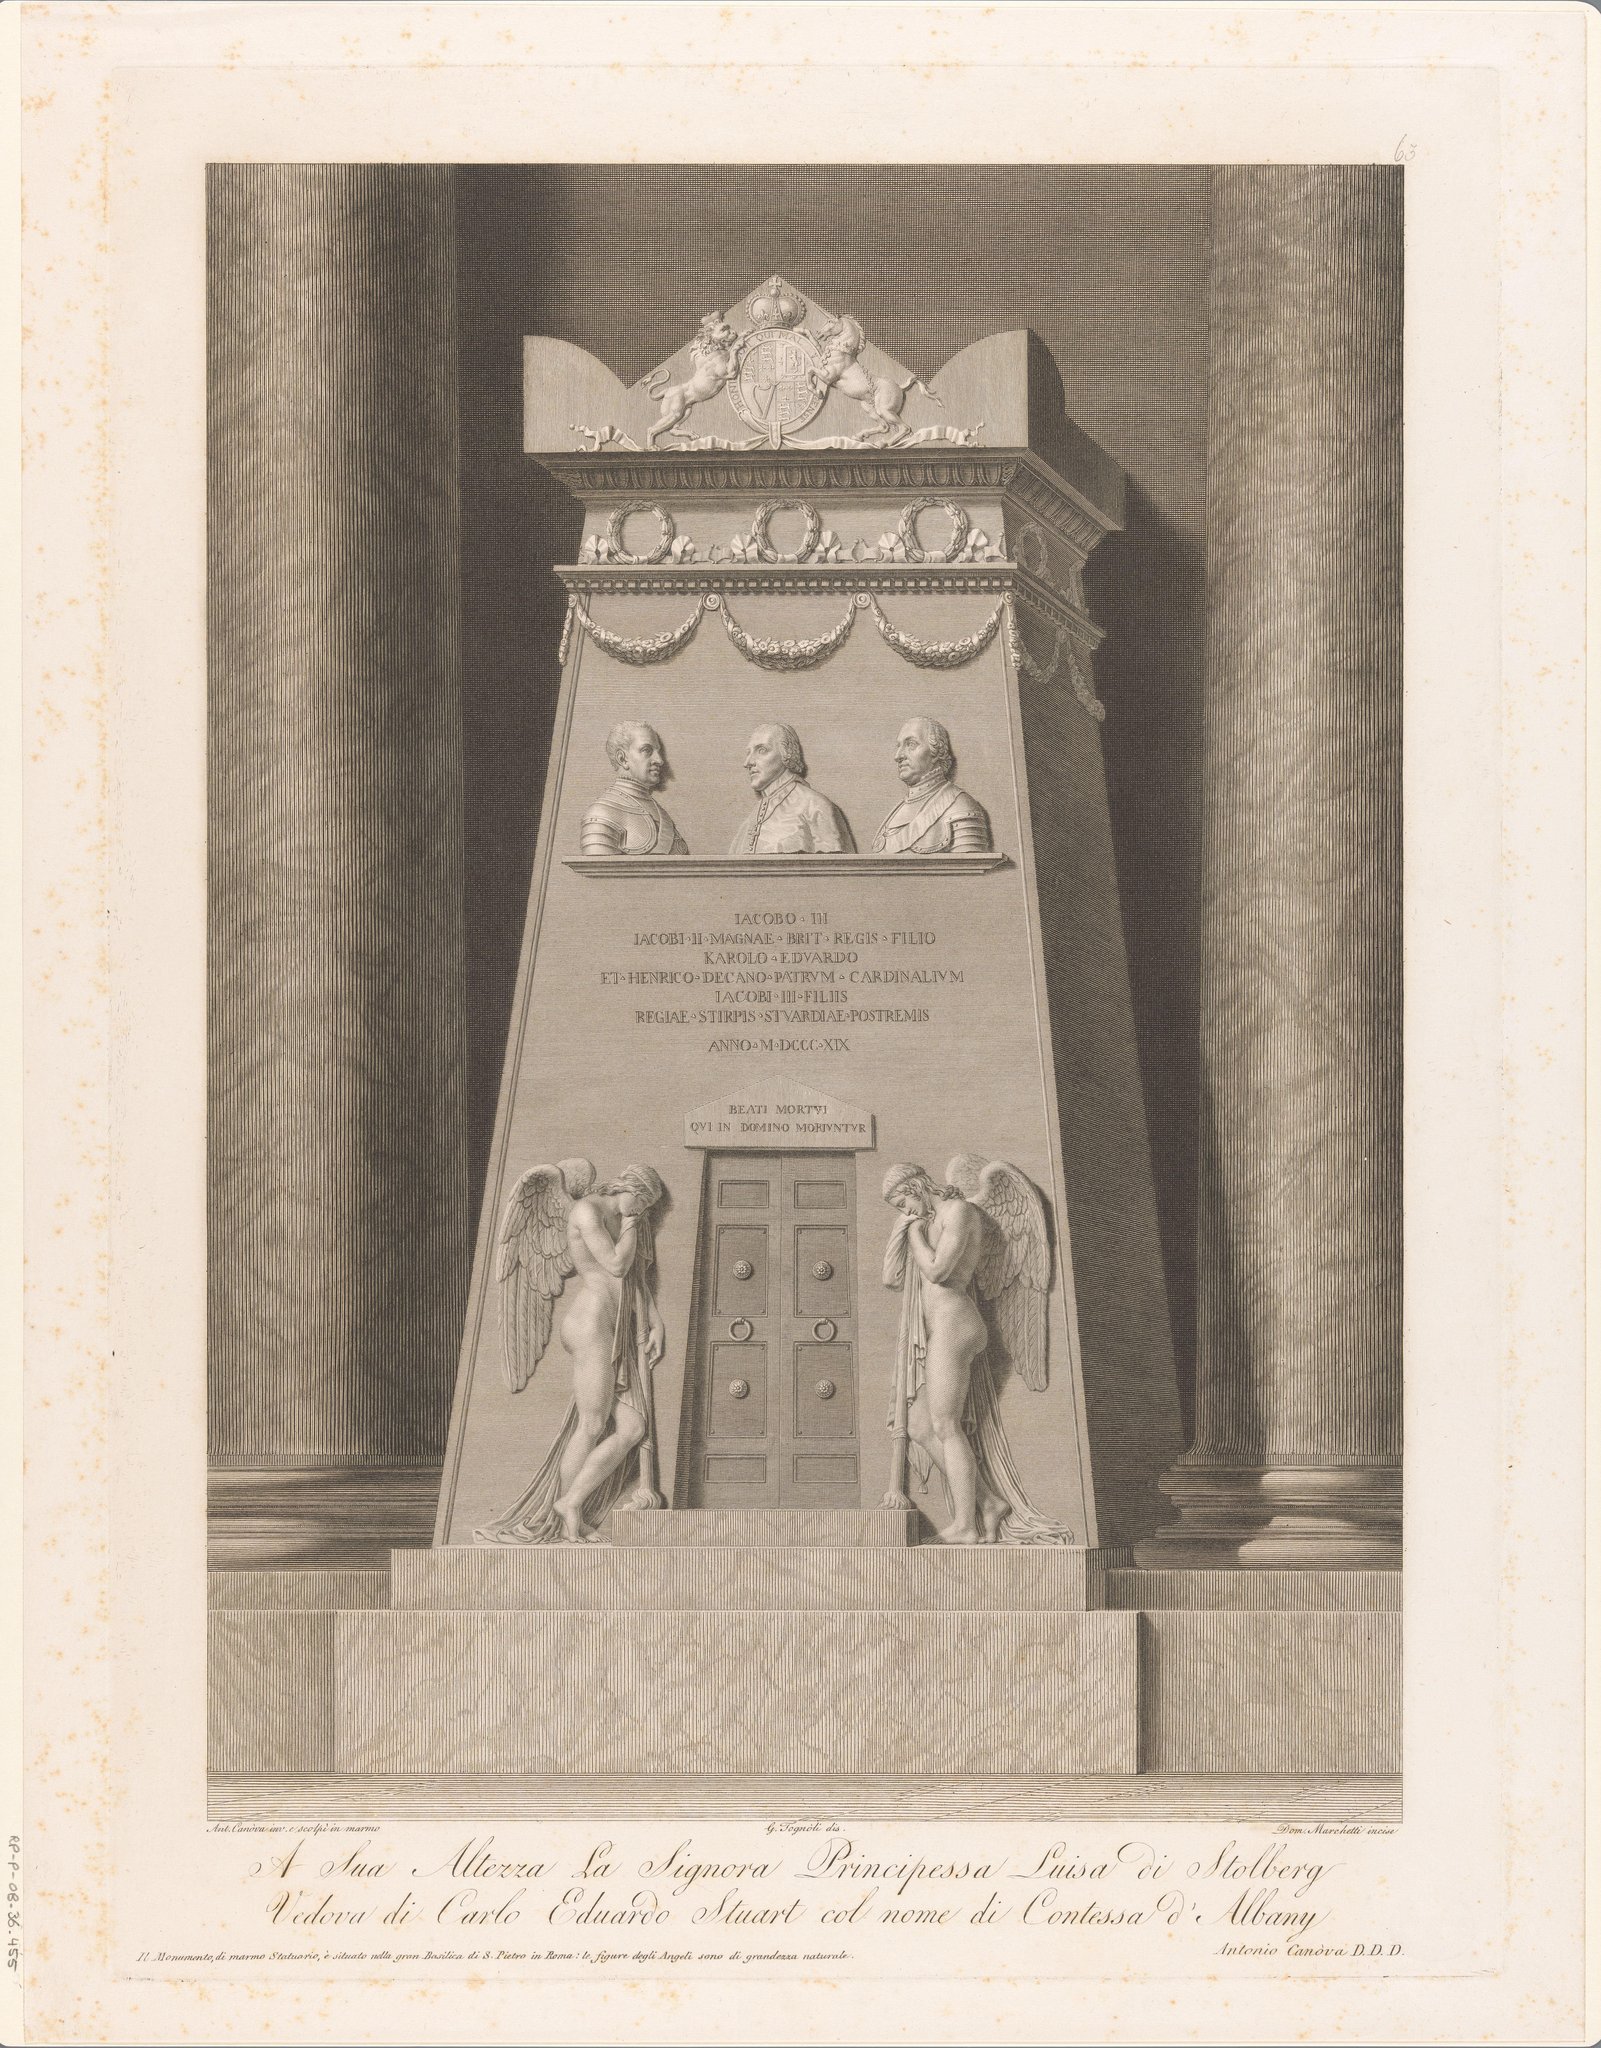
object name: print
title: Graftombe voor drie leden van de Stuart familie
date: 1790-1844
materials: paper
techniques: engraving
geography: italy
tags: london, rome, grave, tomb, piece of sculpture, reproduction of a piece of sculpture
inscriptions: collector's mark: Lugt 12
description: Deze prent maakt deel uit van een reeks van onbekende omvang met voorstellingen van sculpturen van Antonio Canova door verschillende prentmakers naar tekeningen van Giovanni Tognolli. Het grafmonument door Canova bevindt zich in de Sint-Pietersbasiliek te Vaticaanstad.